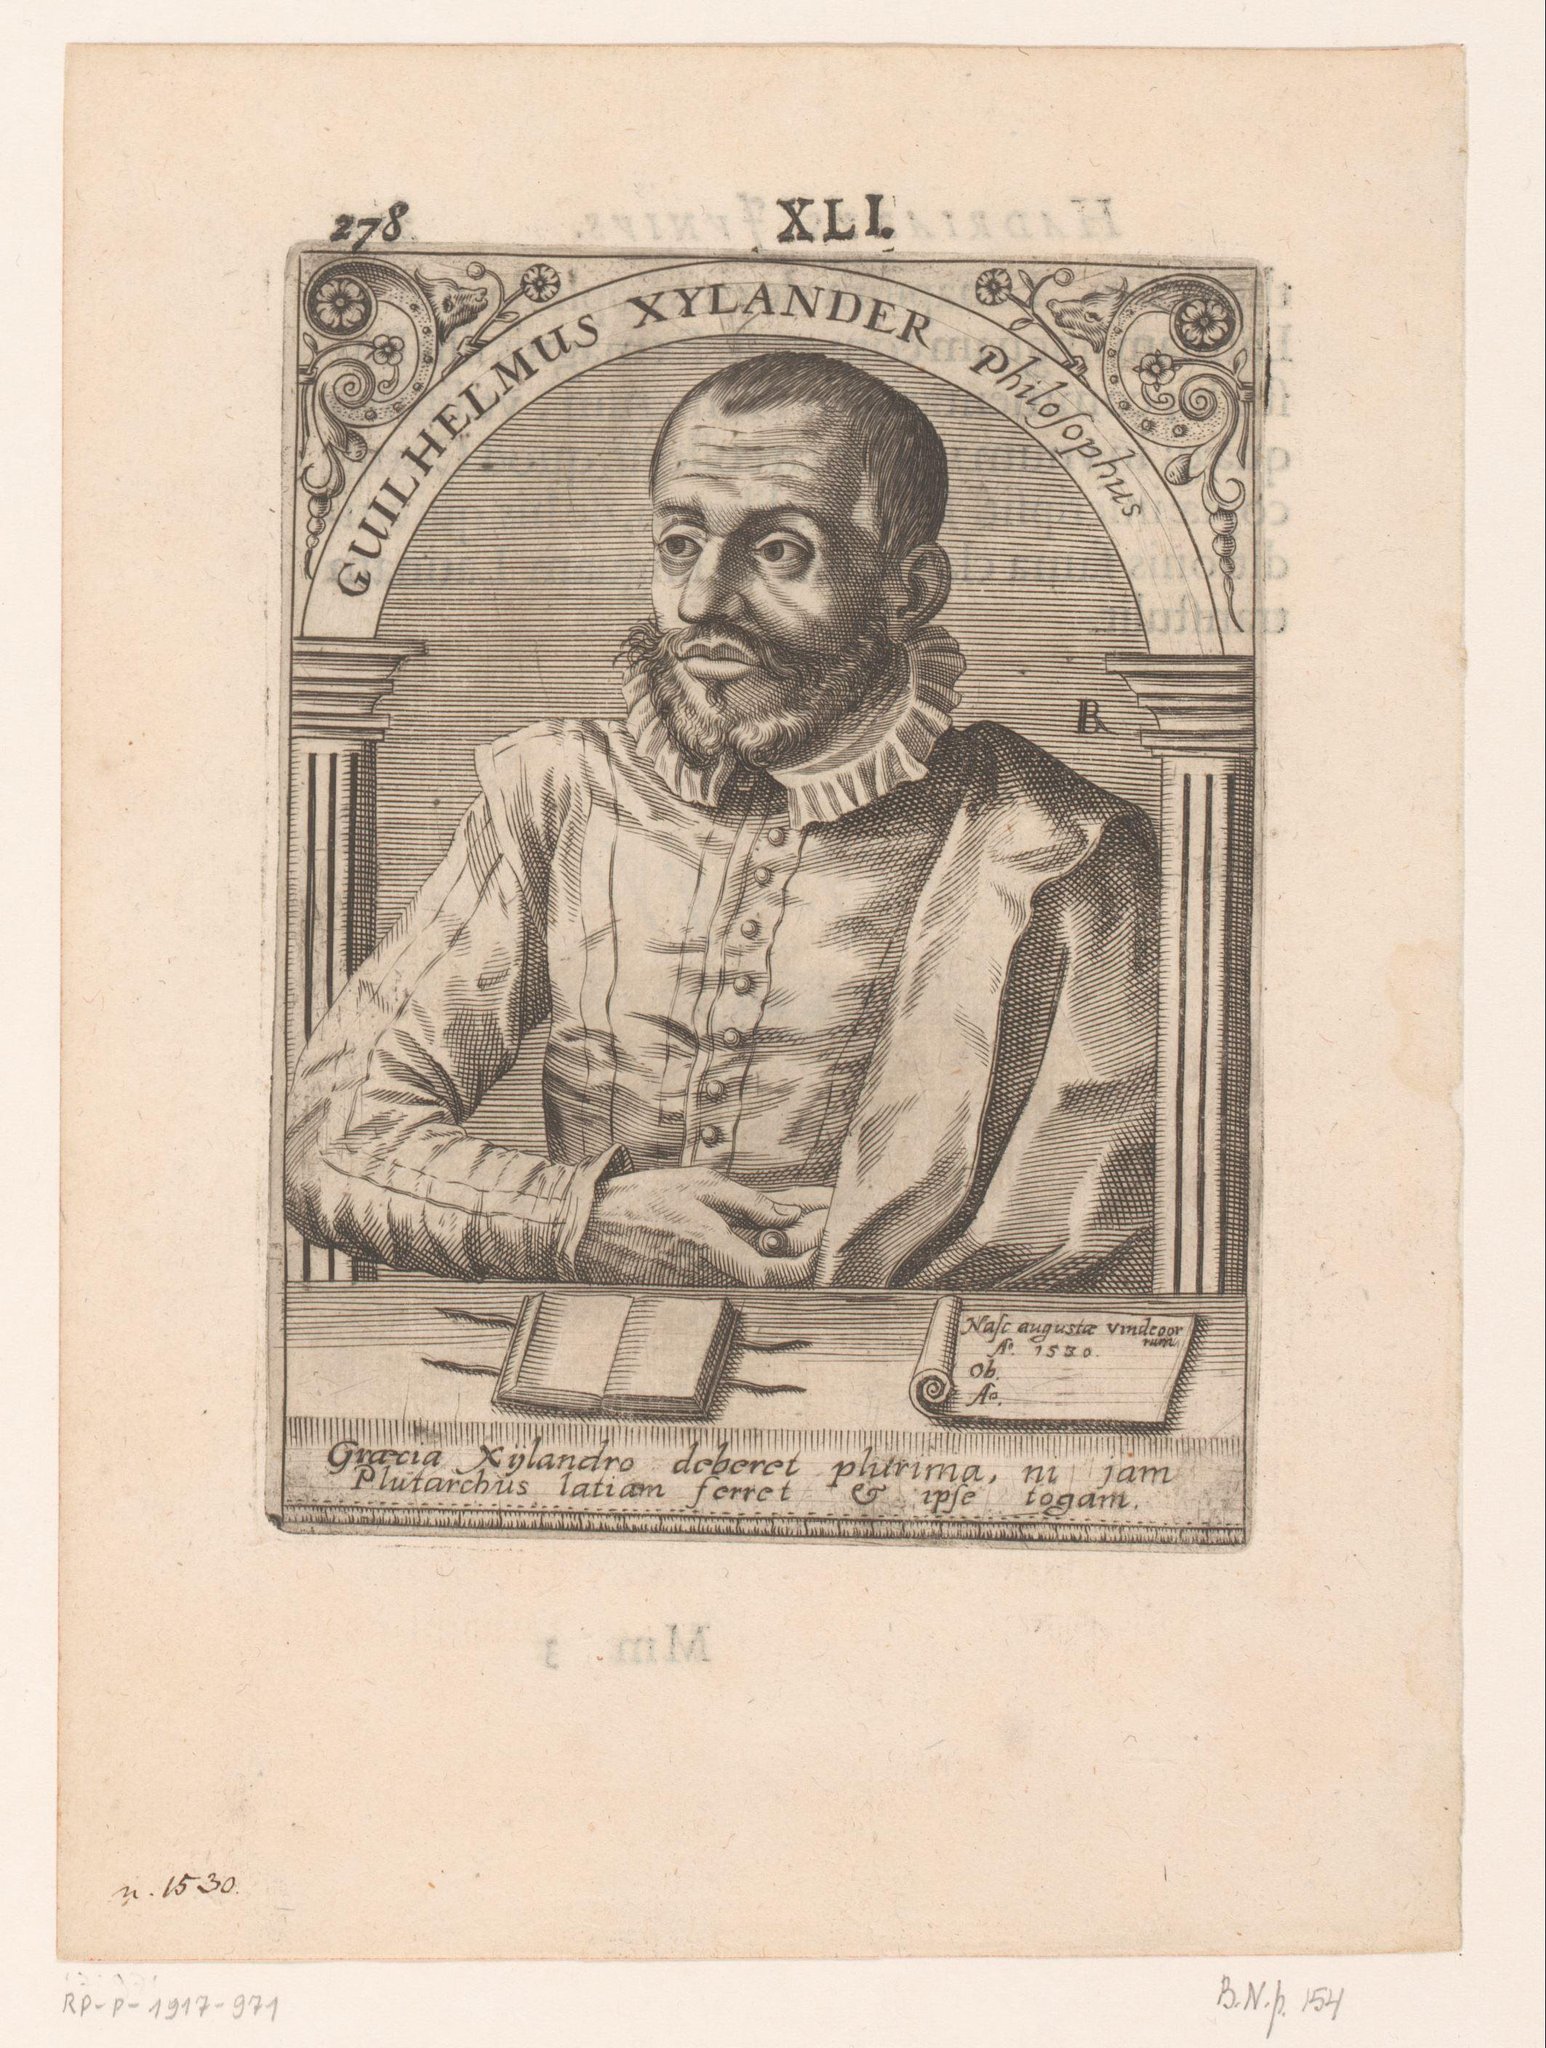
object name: print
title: Portret van Wilhelm Xylander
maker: robert boissard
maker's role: print maker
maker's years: 1570-1611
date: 1597-1599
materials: paper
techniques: engraving, letterpress printing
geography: france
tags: augsburg, historical persons, book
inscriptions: collector's mark: Lugt 2228, inscription: ‘n. 1530.’